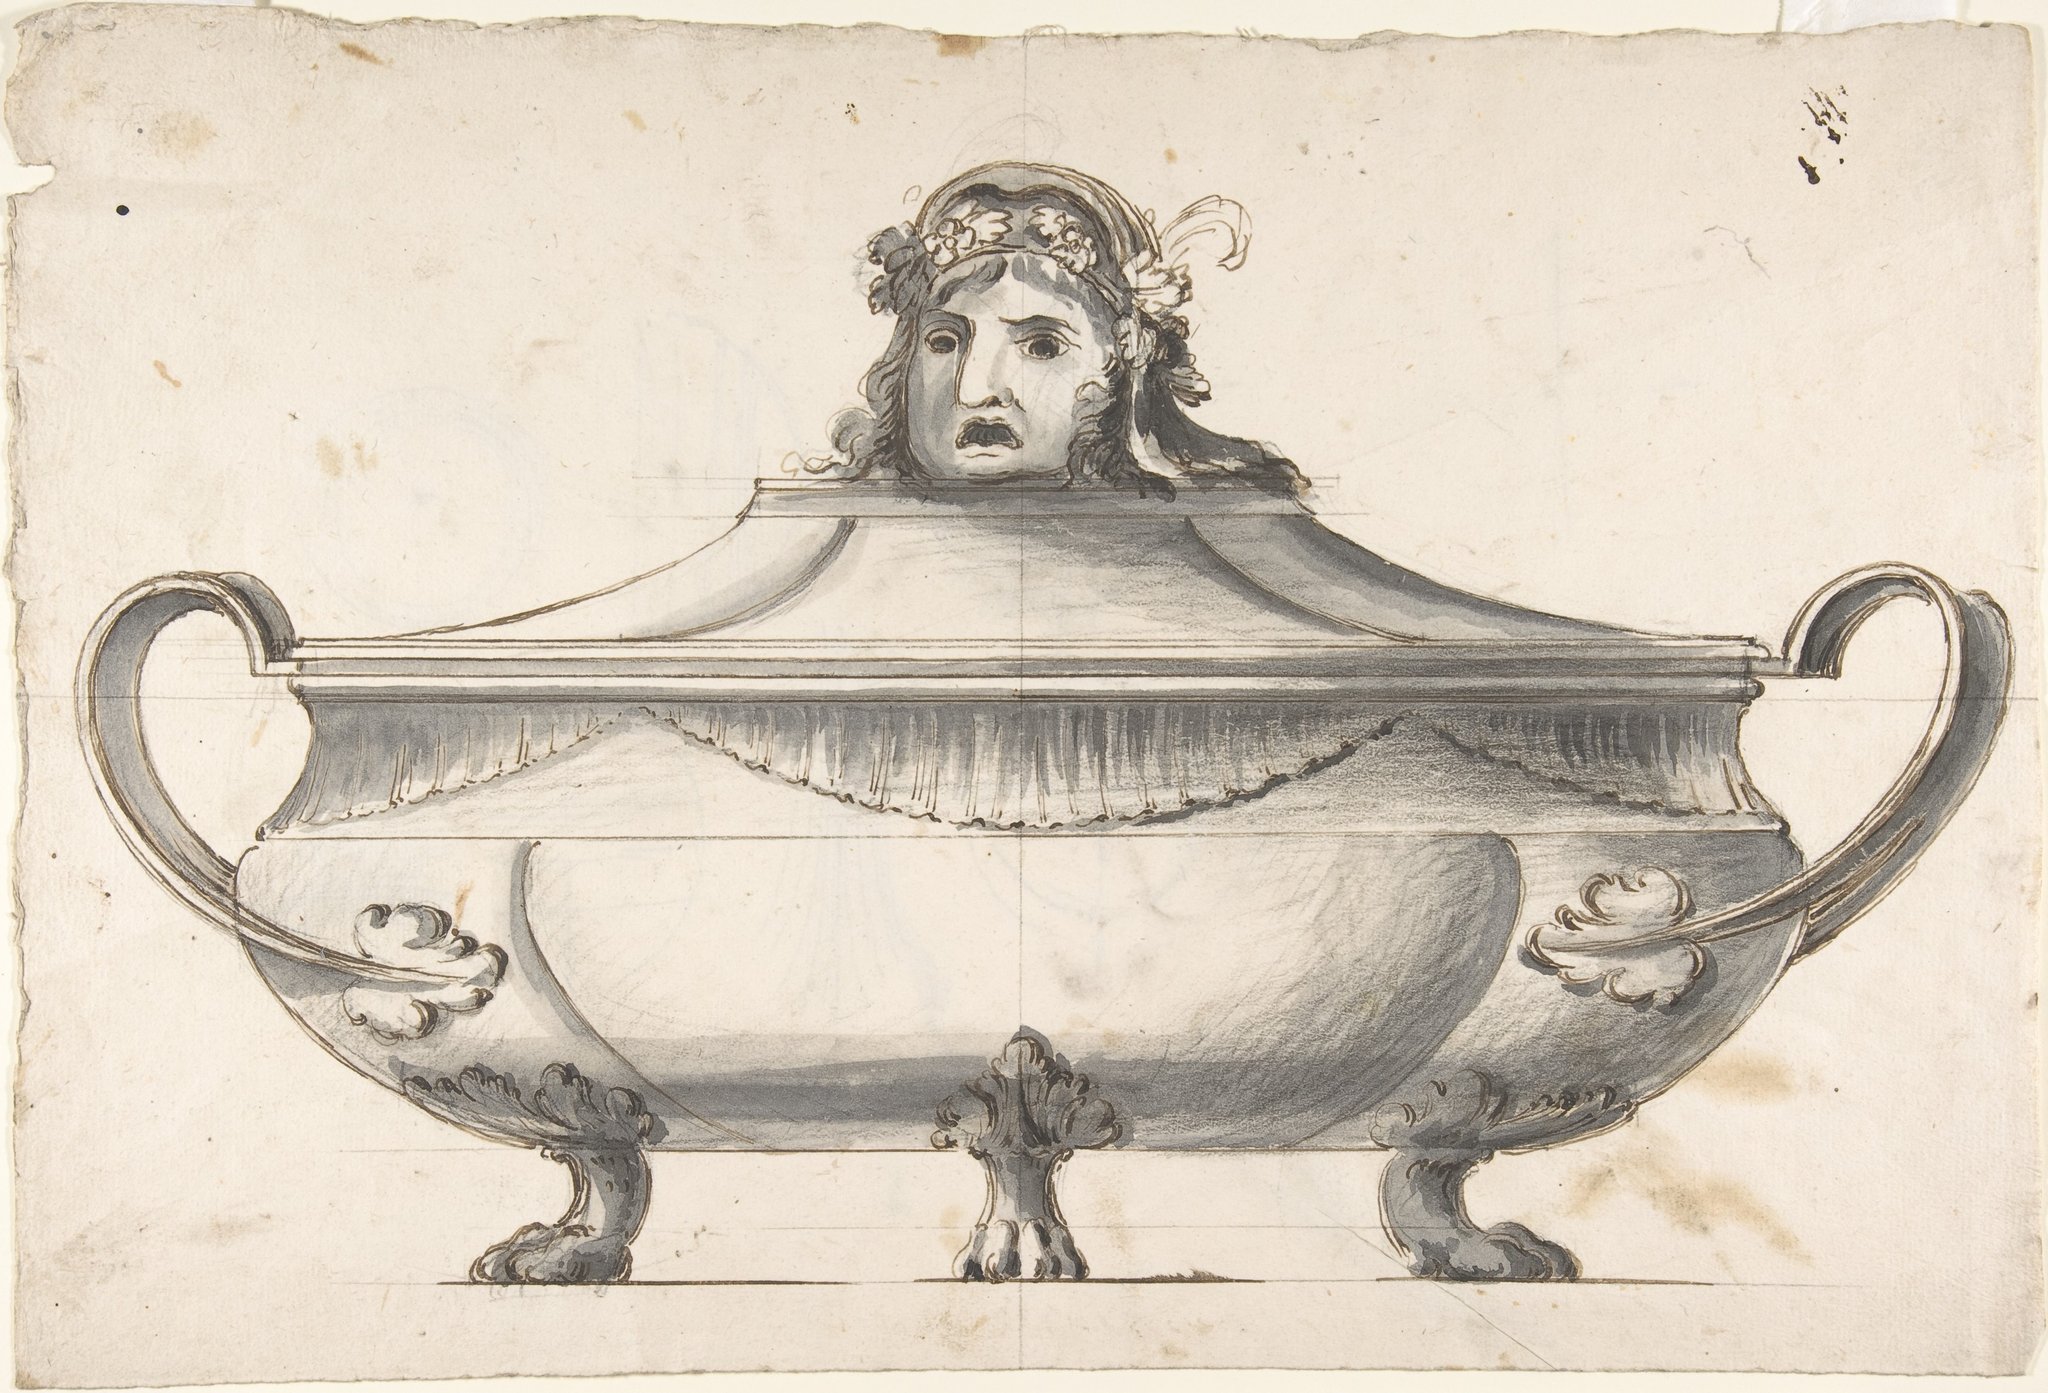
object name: drawing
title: Tureen, Finial with Mask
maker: anonymous, italian, 19th century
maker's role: artist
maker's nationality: italian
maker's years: 1800-1900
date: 1800-1900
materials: ink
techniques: pen, wash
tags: masks,tureens